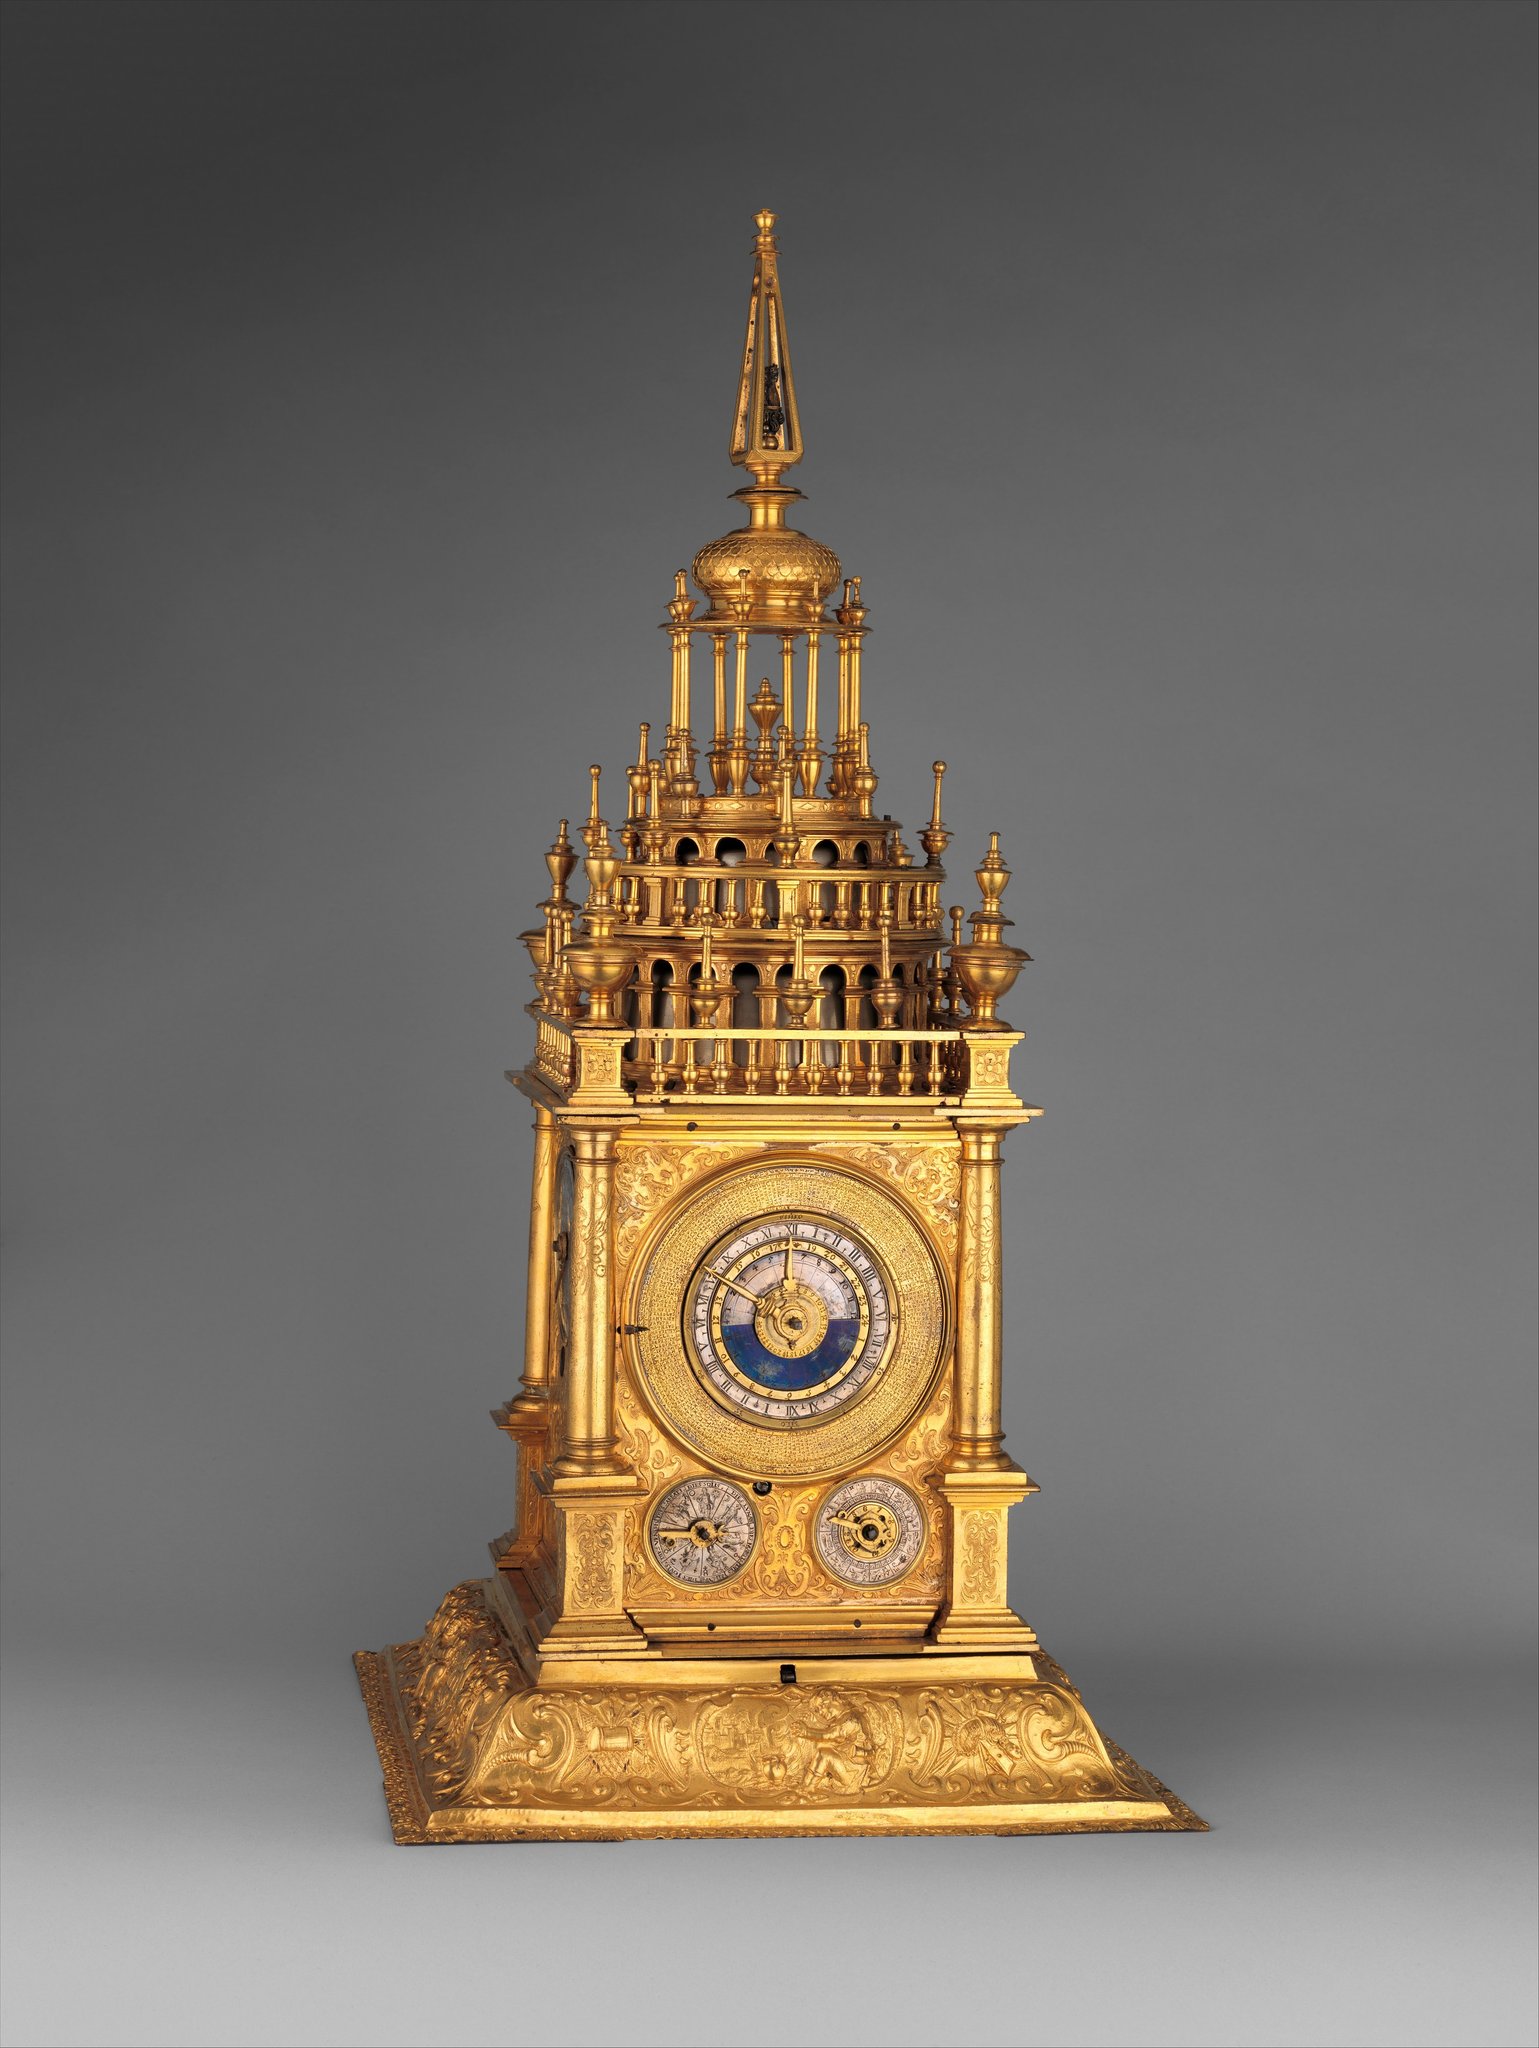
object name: astronomical table clock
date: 1626-1650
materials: brass, gilt brass, gilt copper, silver, steel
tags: astronomy,zodiac